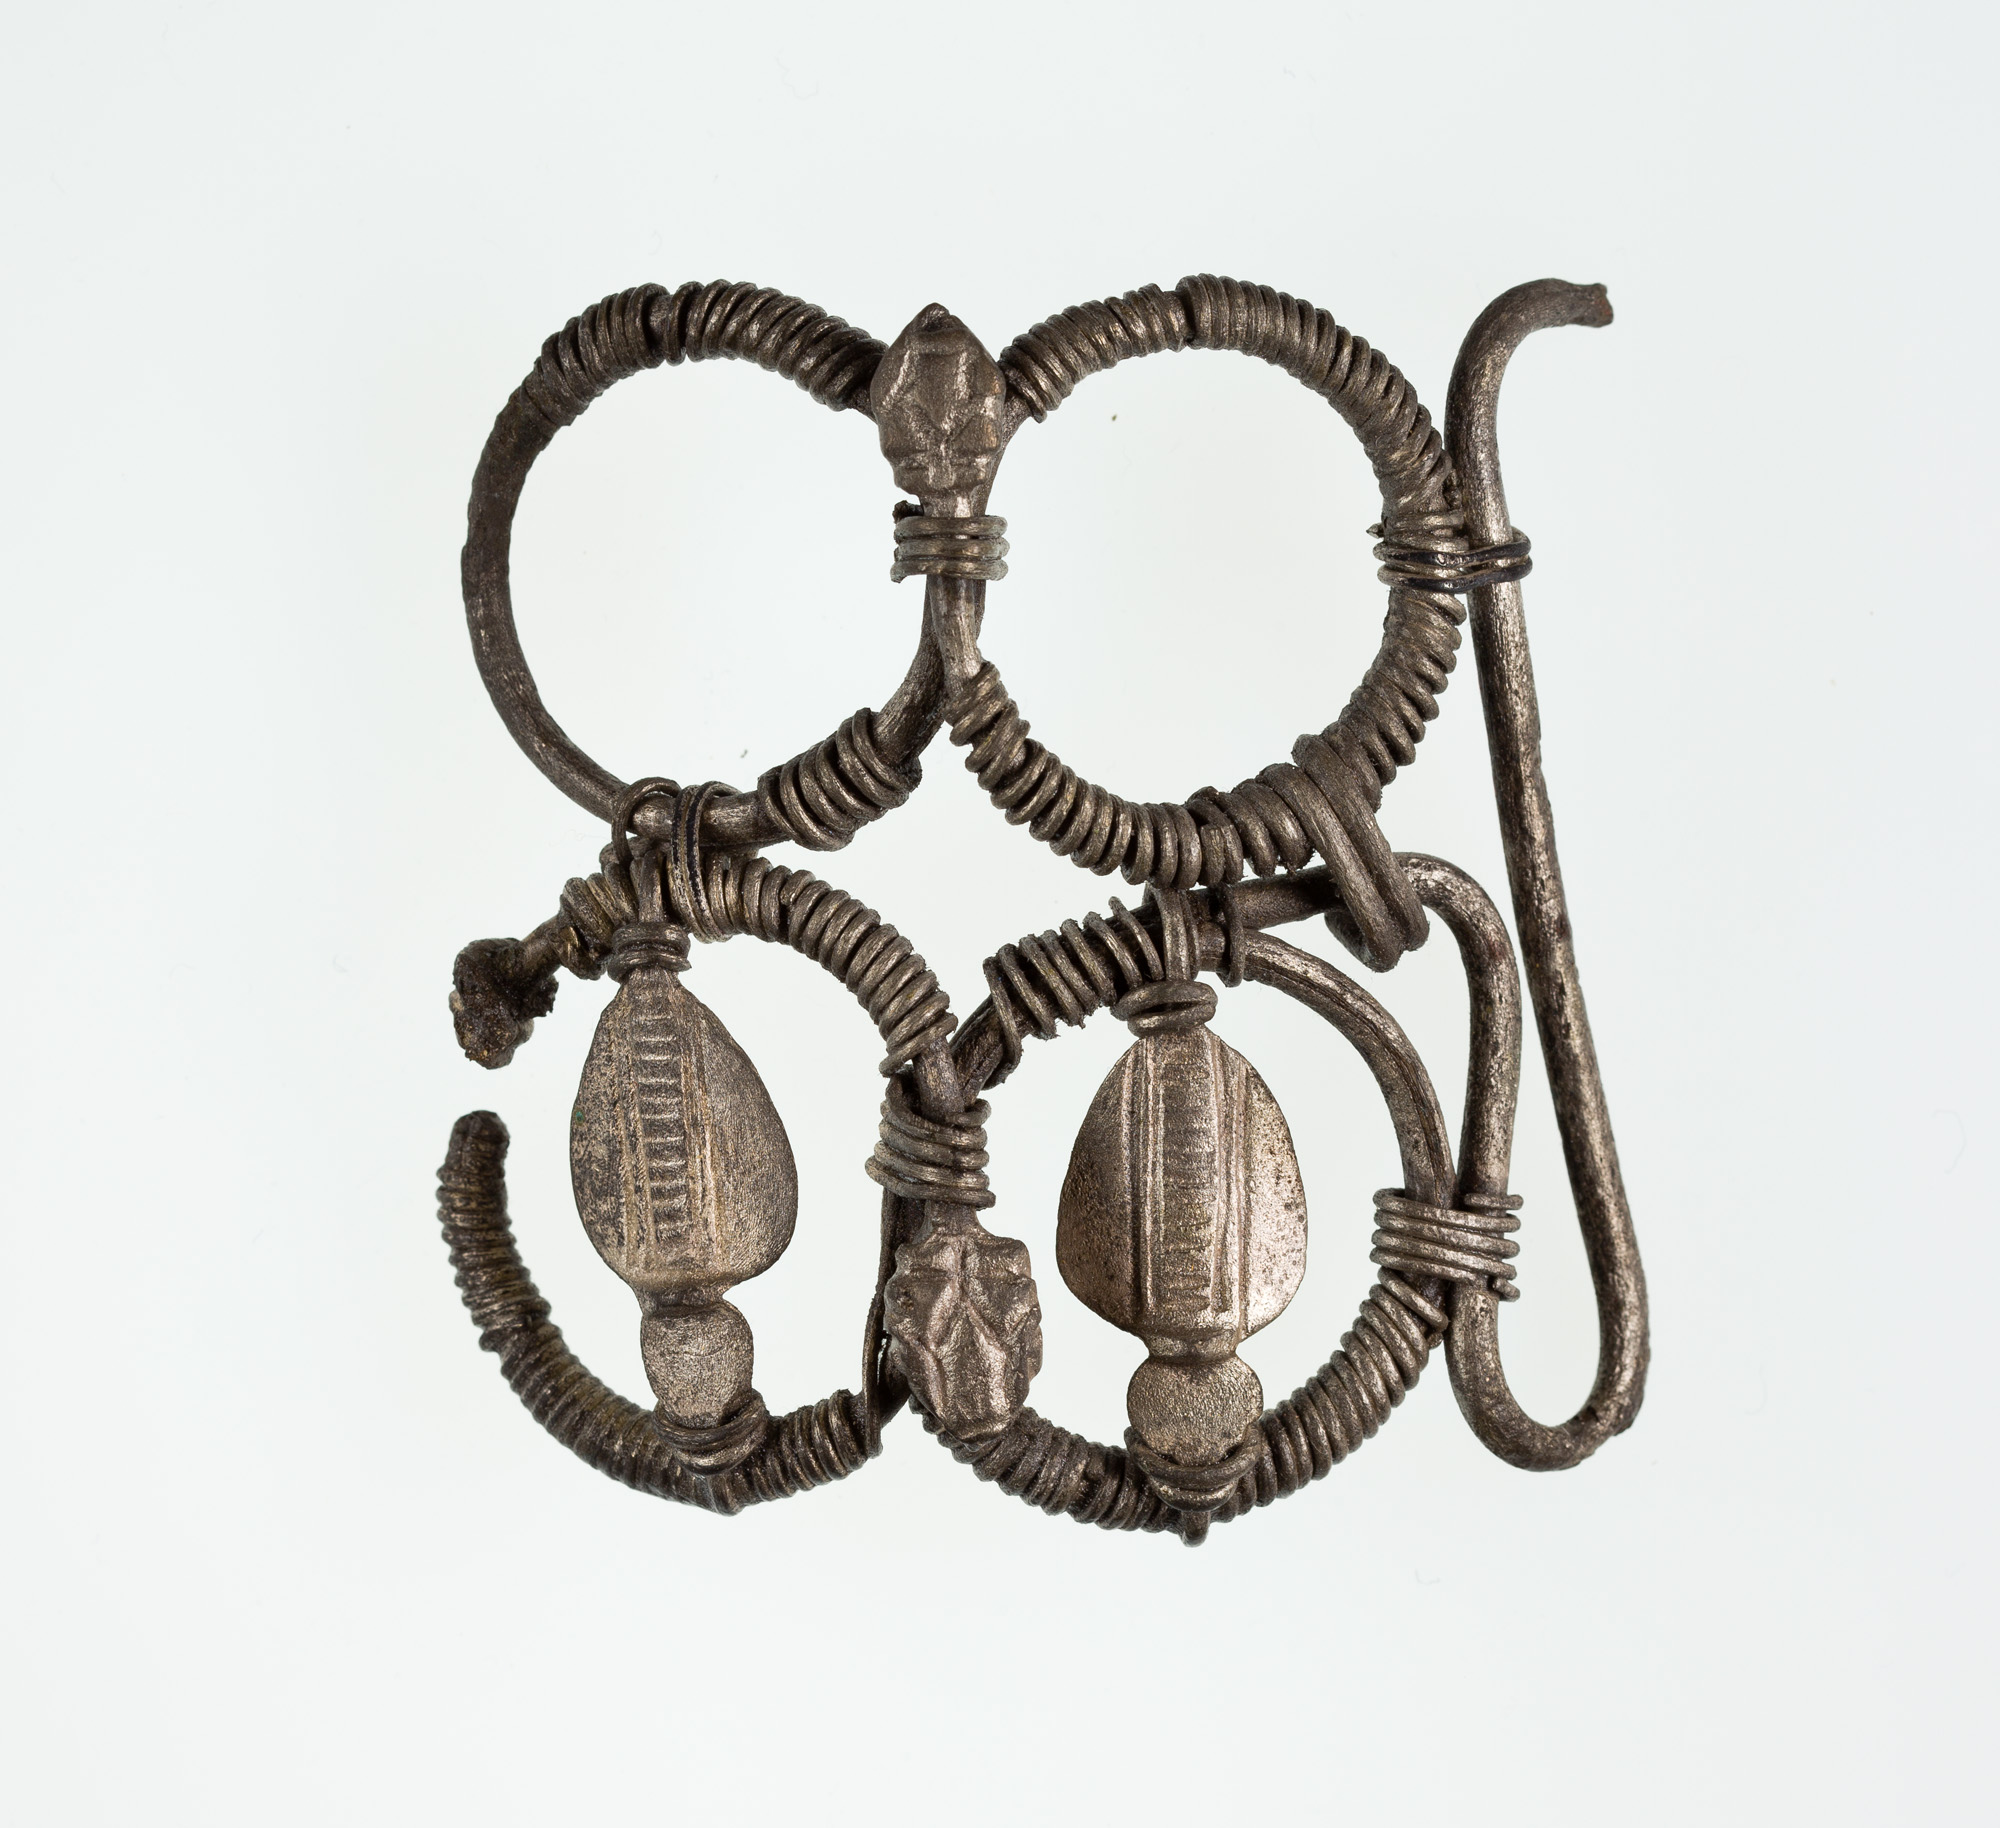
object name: bracelet or armlet, uraei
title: Part (?) of a bracelet or armlet with uraei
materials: silver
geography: egypt